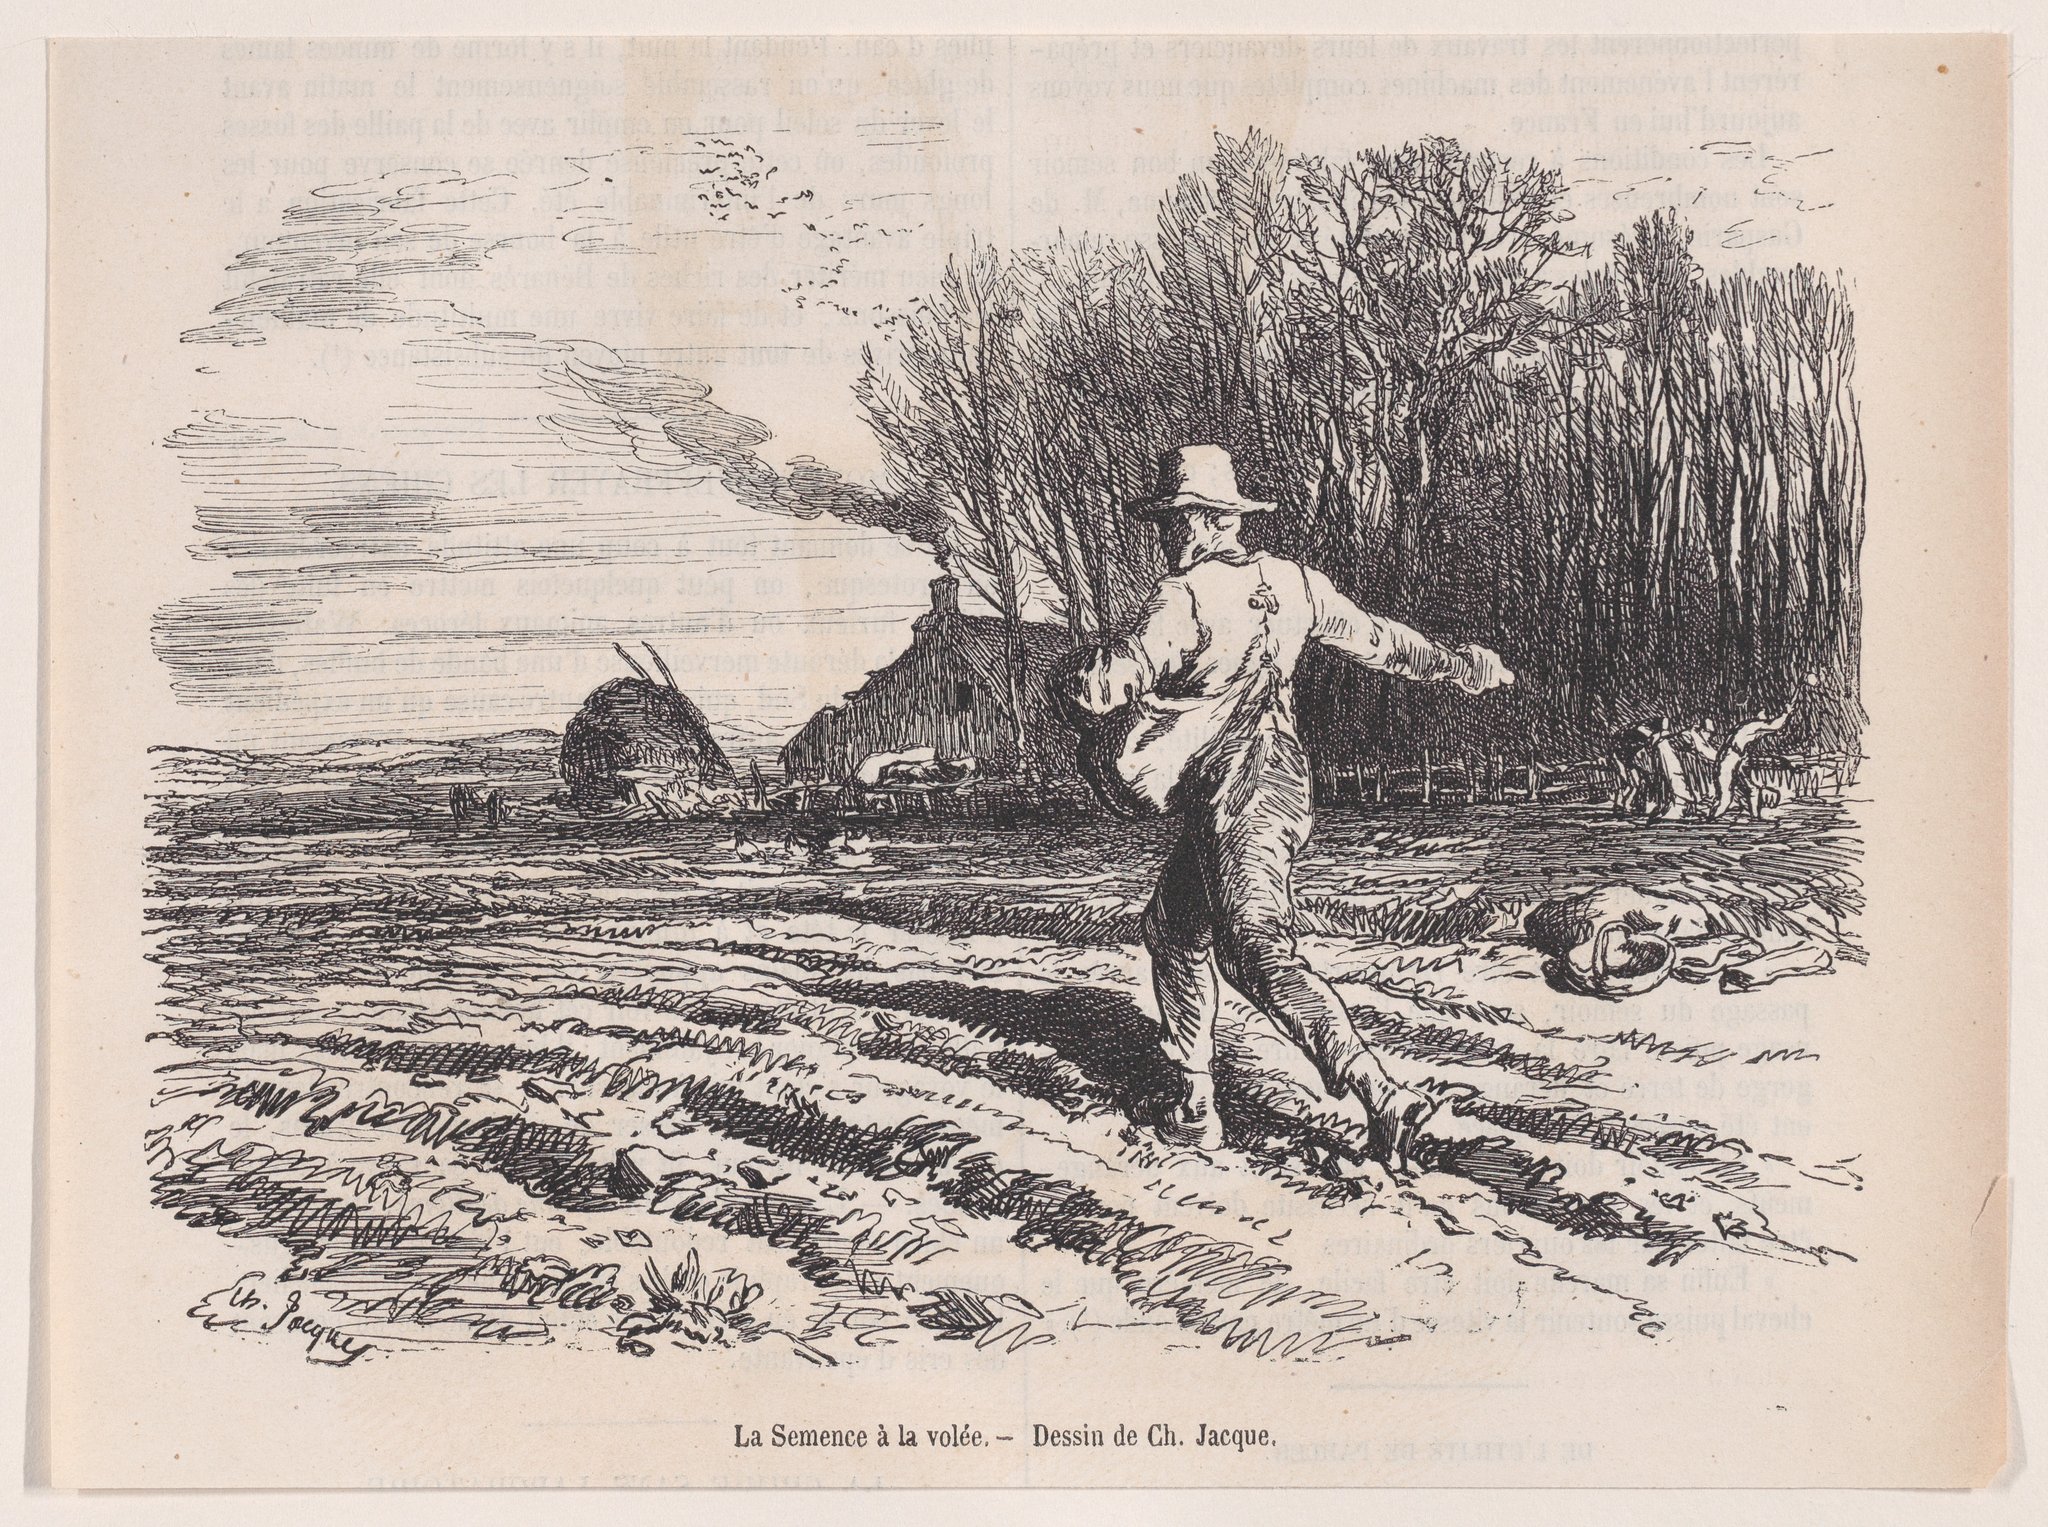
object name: print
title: Scattering Seed, from "Le Magasin Pittoresque"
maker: charles émile jacque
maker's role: artist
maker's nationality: french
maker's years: 1813-1894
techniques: engraving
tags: farms,men,agriculture,working